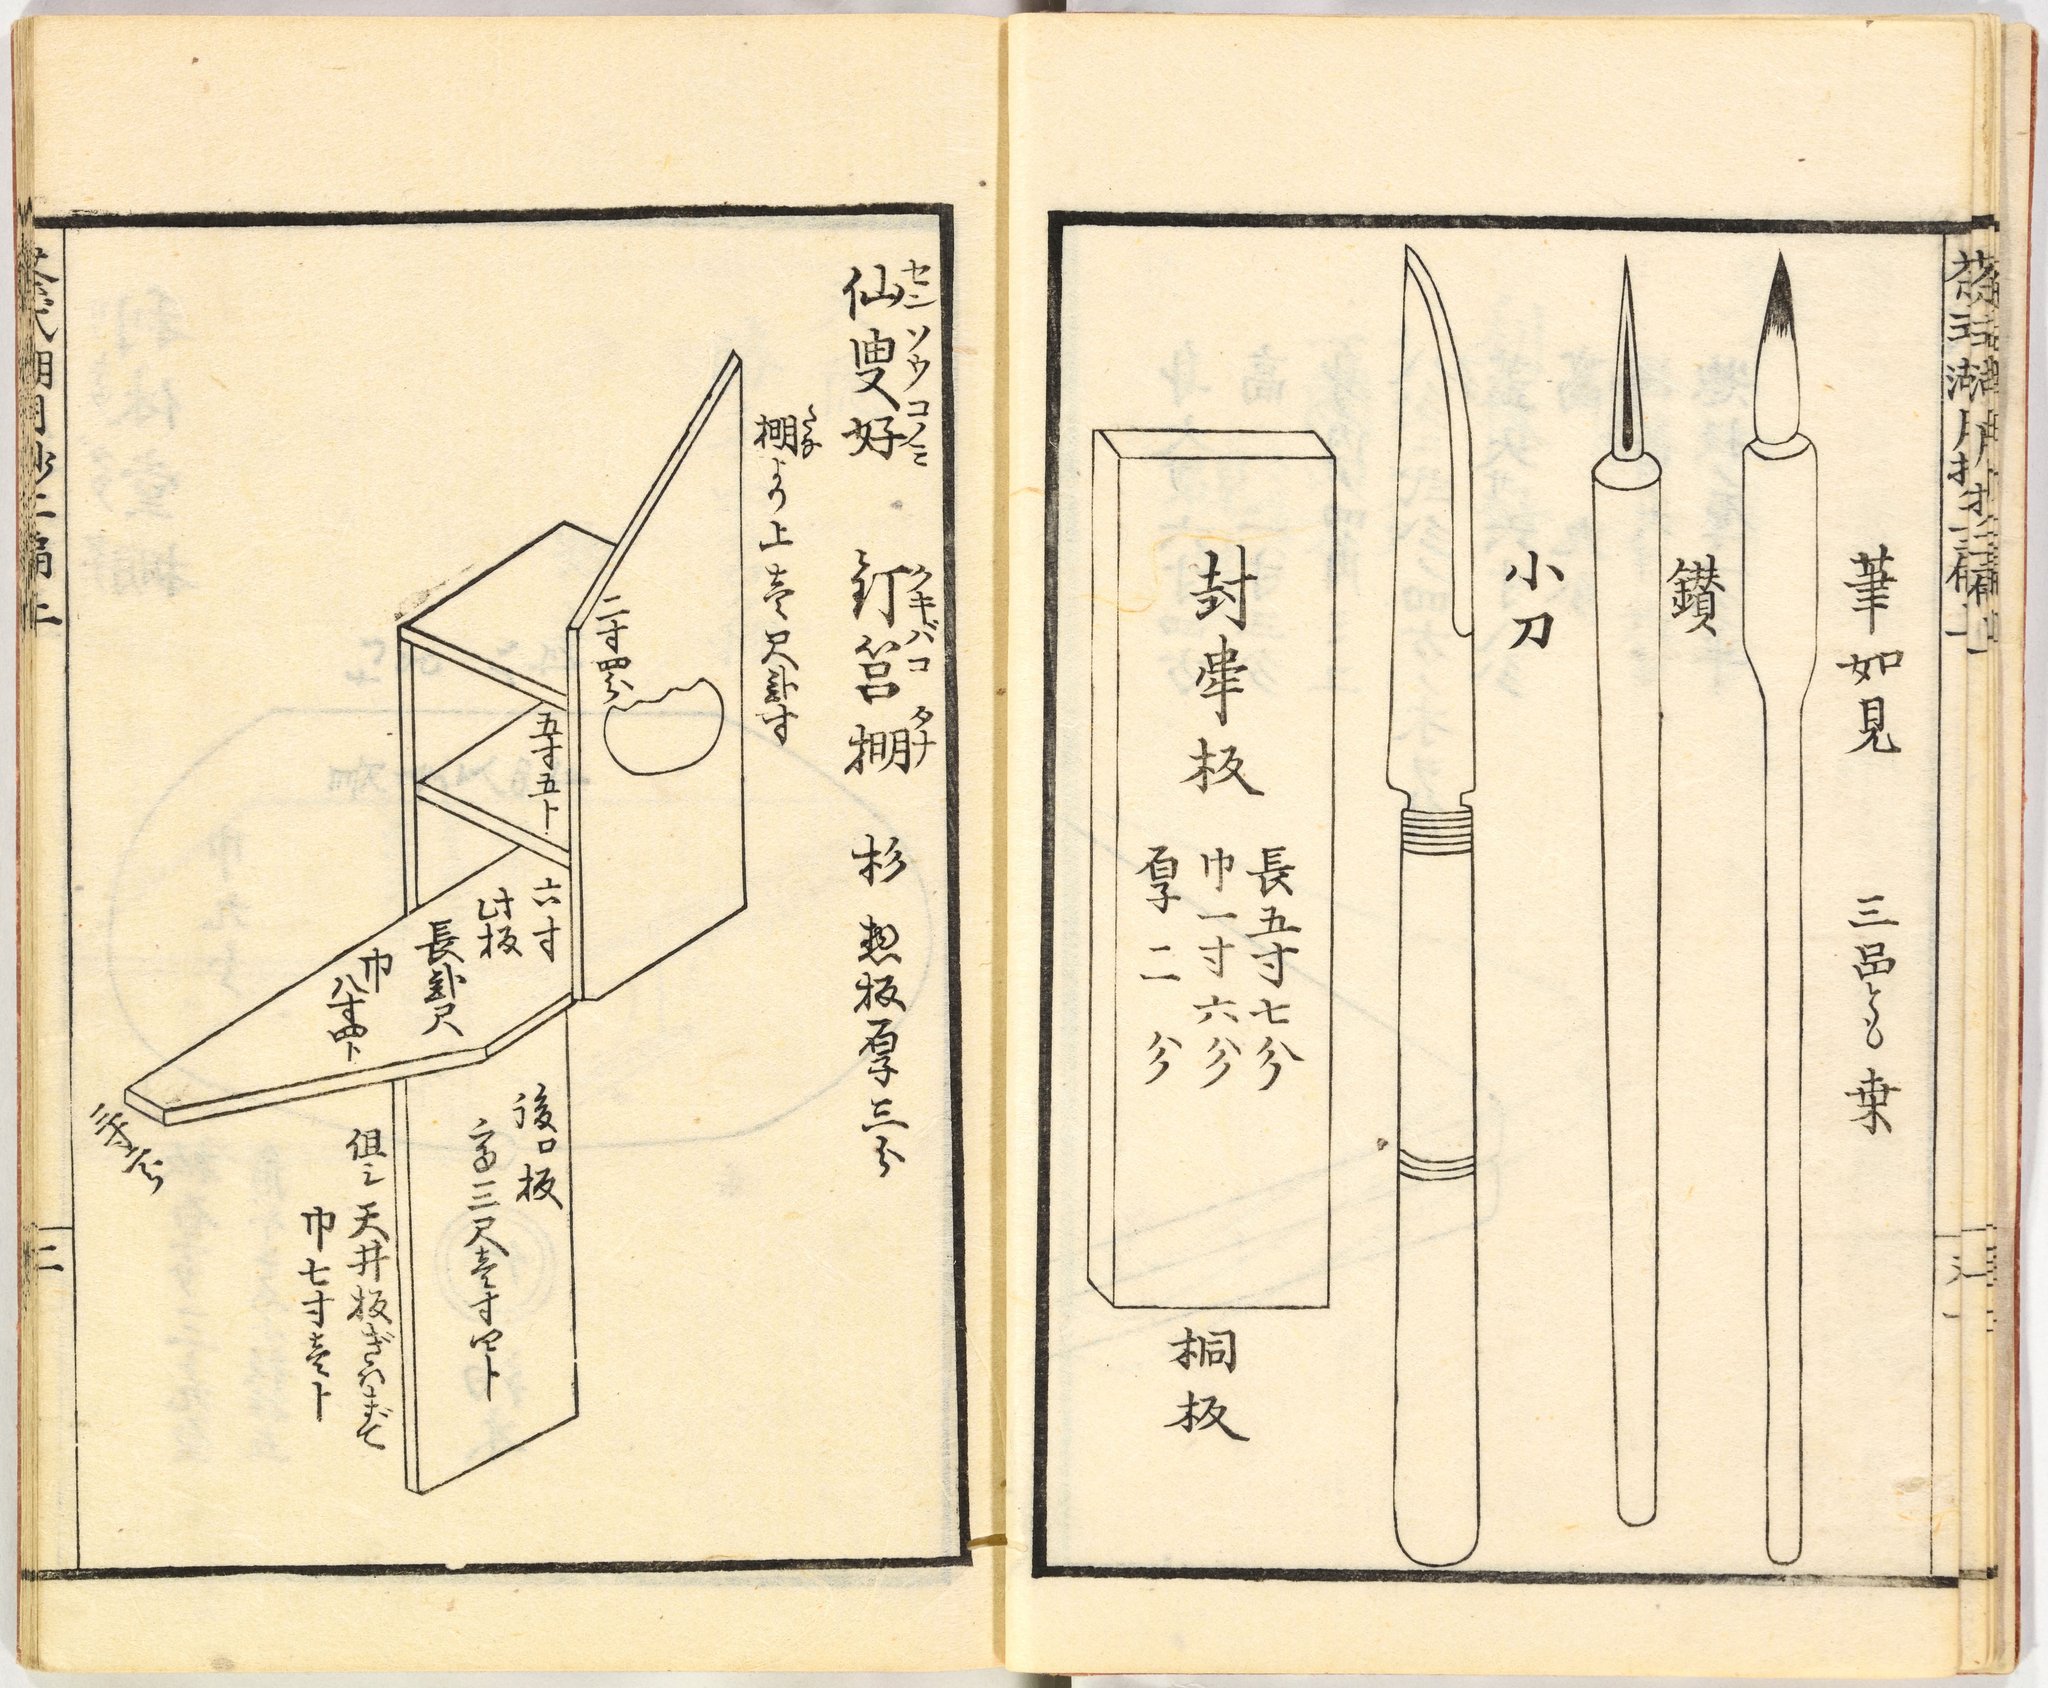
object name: illustrated book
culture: japanese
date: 1893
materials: ink, paper